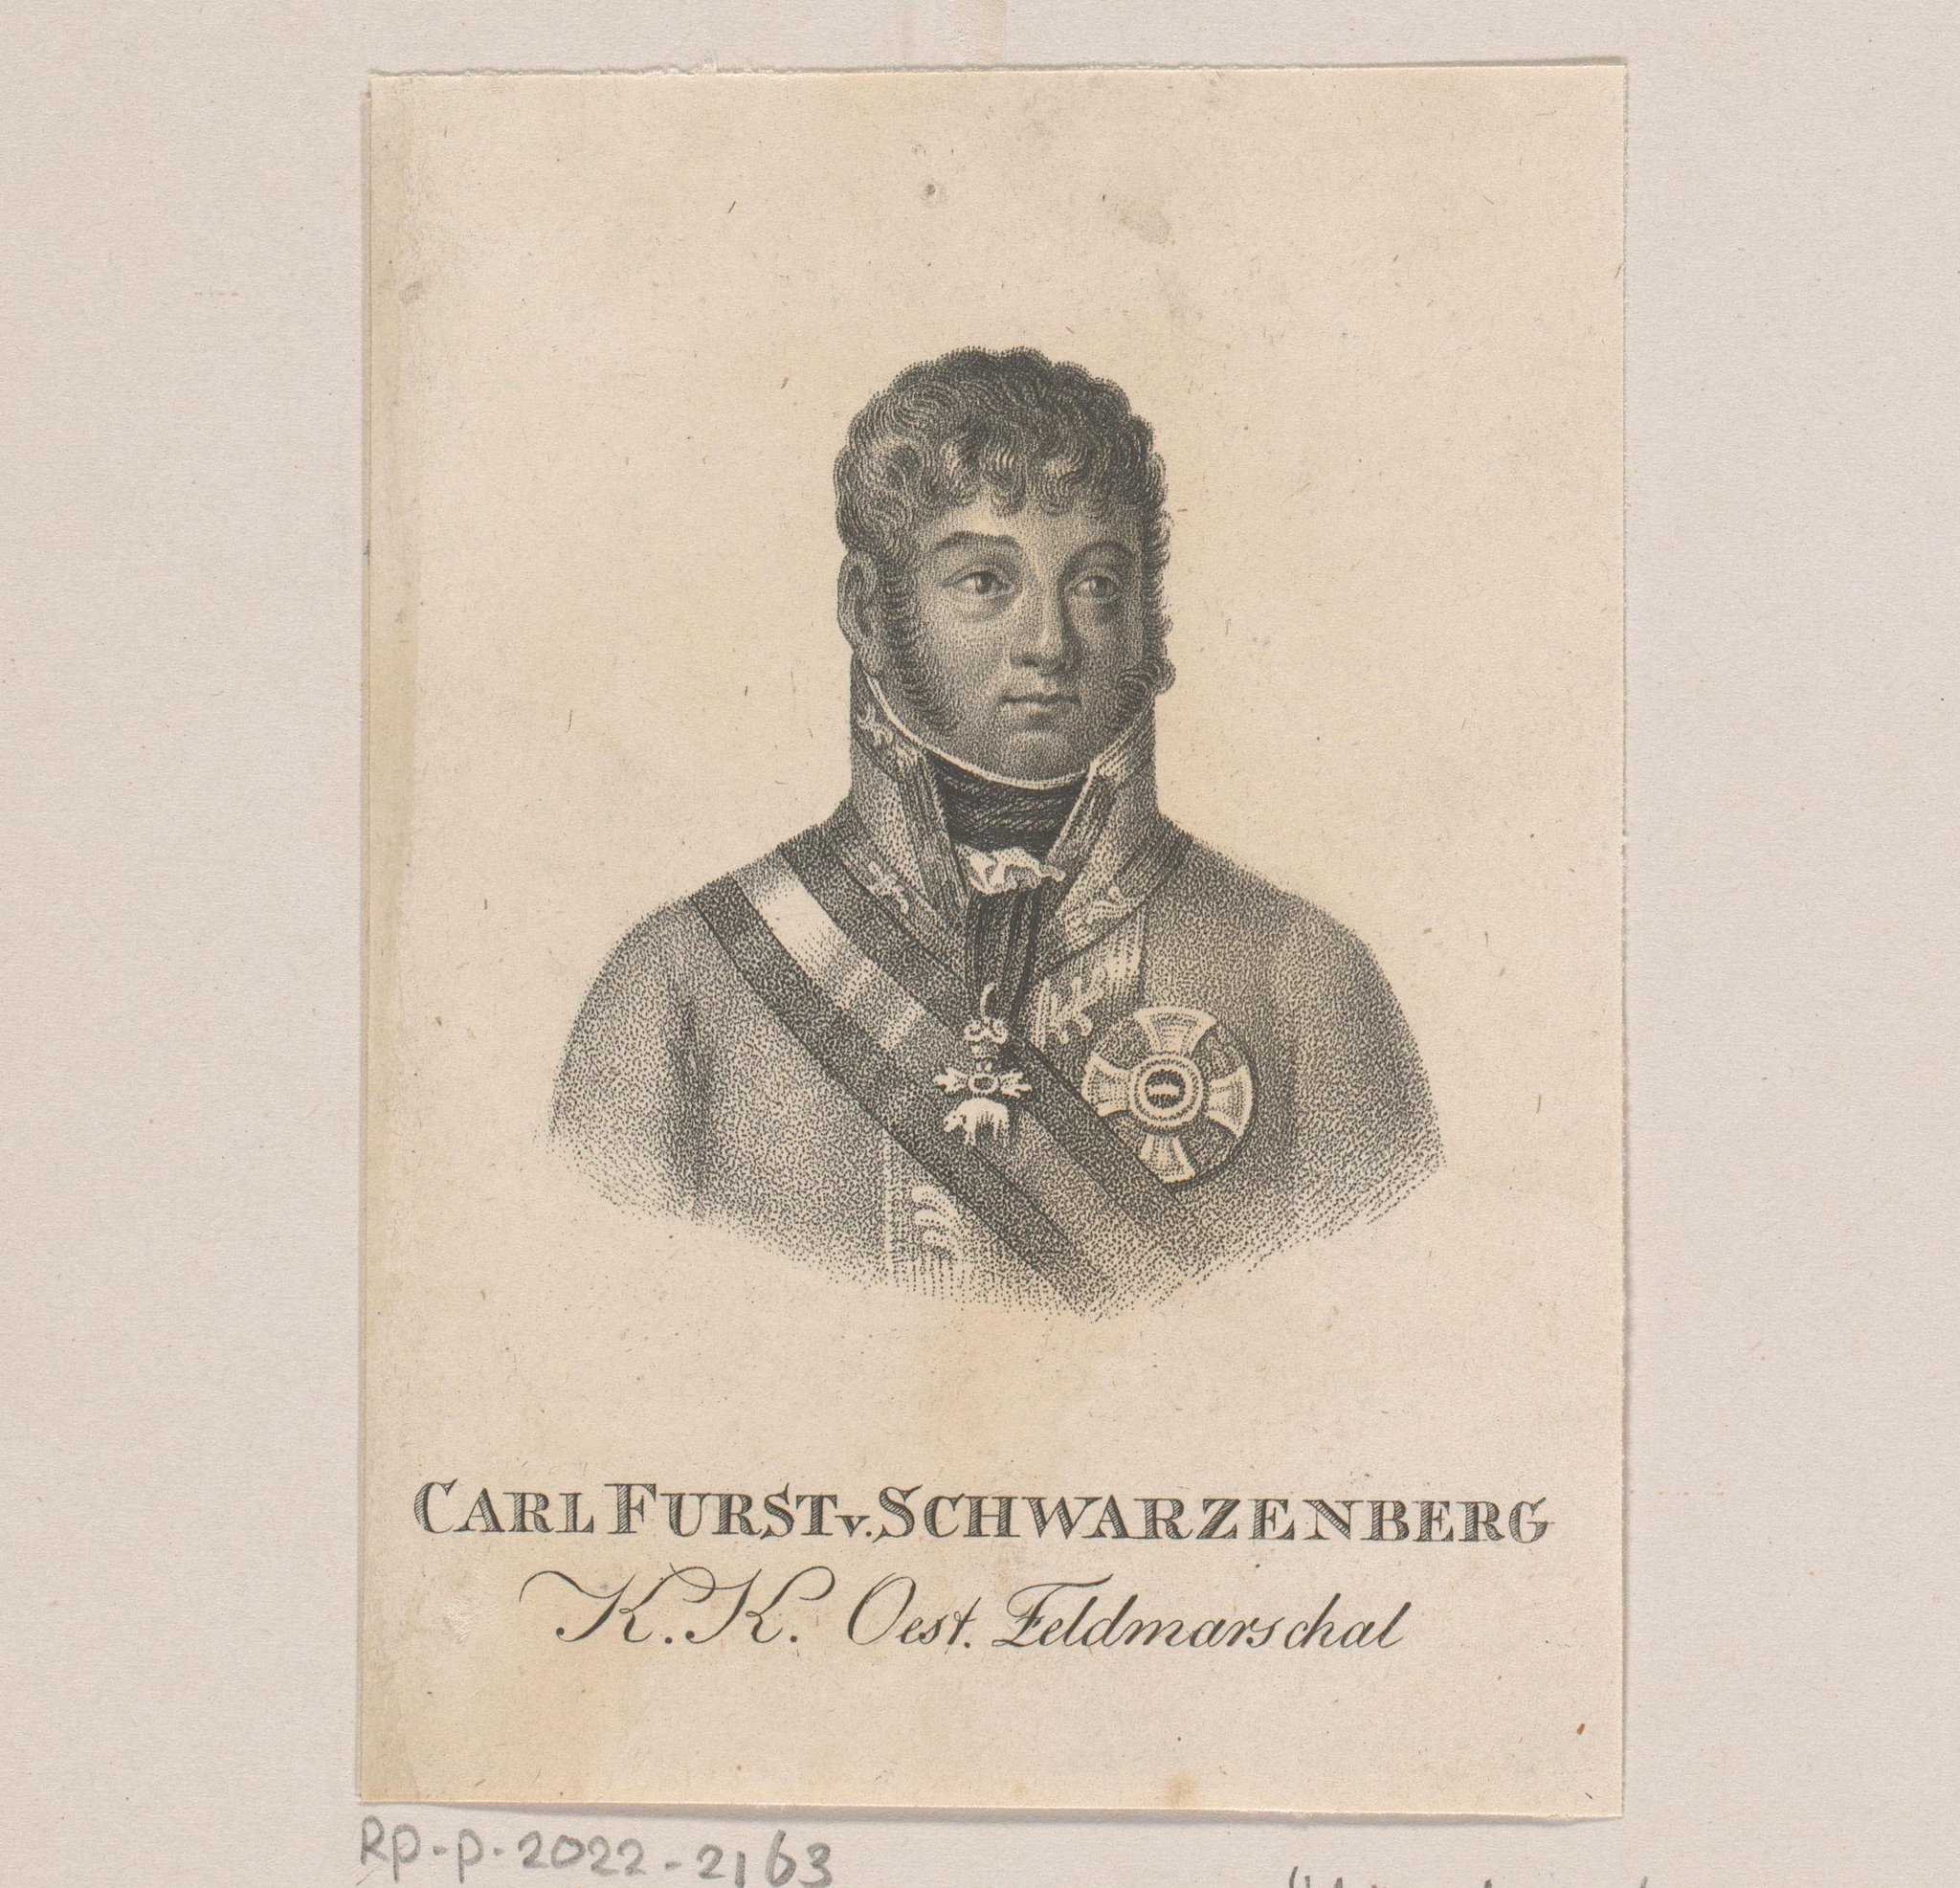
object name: print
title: Portret van Carl Philipp von Schwarzenberg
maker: Anonymous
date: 1812-1899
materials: paper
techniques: etching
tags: vienna, commander-in-chief, general, marshal, historical persons, medals and other marks of military honour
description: Met tweeregelig onderschrift in het Duits.